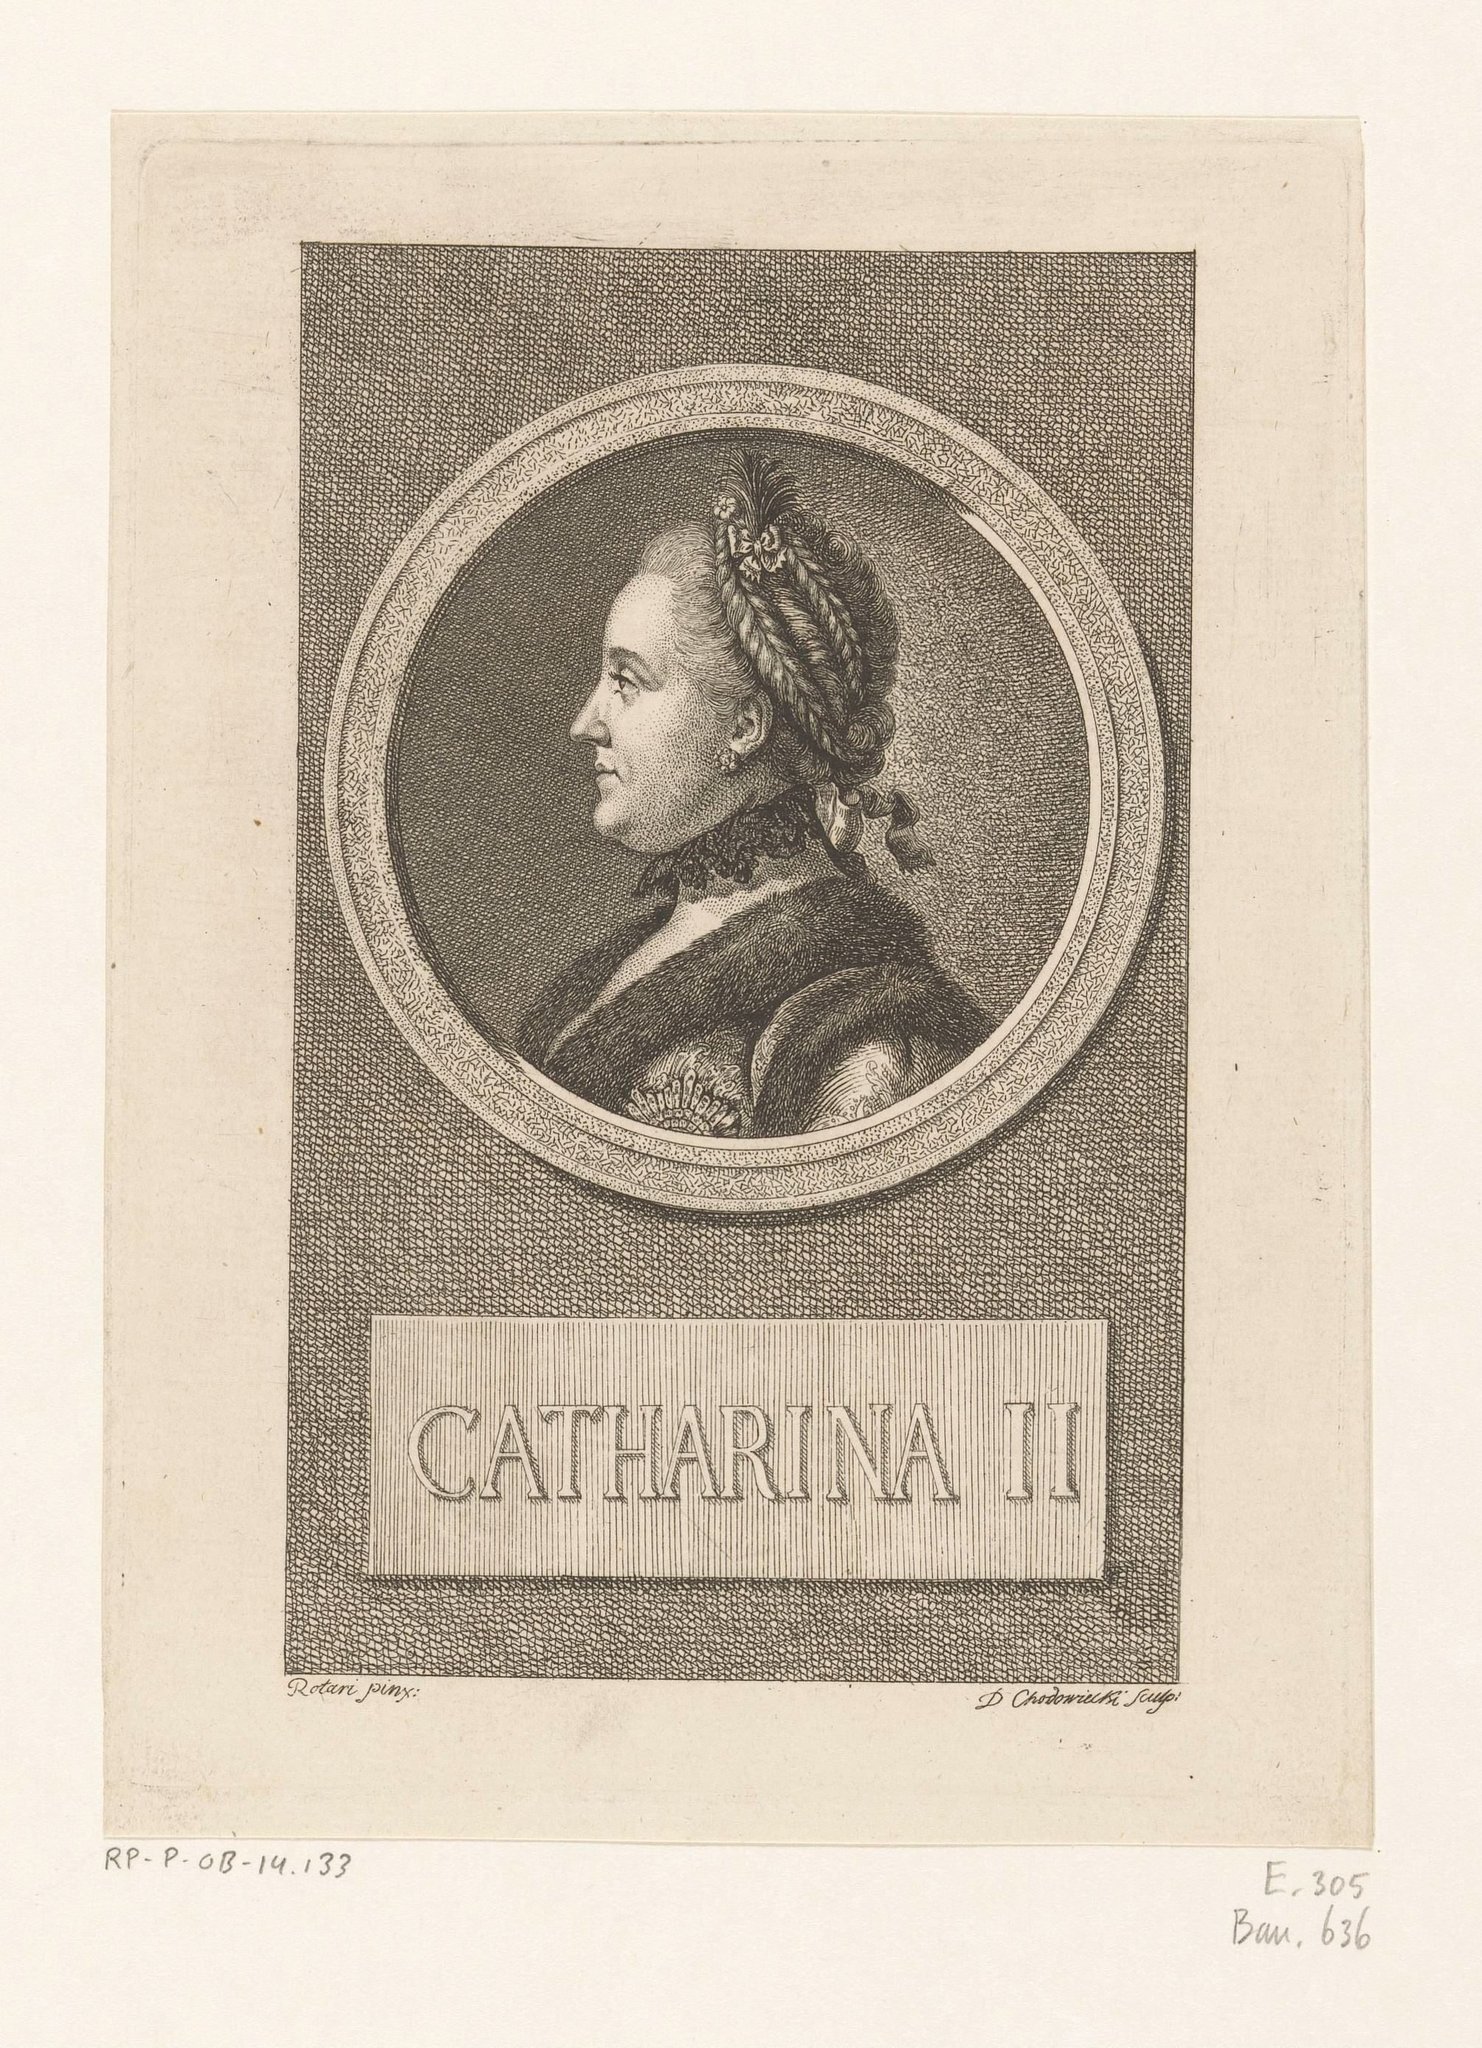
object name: print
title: Portret van Catharina de Grote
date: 1779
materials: paper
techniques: etching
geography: berlin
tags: catharina de grote, historical persons - bb - woman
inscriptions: collector's mark: Lugt 240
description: Prent ook gebruikt in: Krünitz, Johann Georg. Oekonomische Encyklopädie. Berlijn: Joachim Pauli, 1779, dl. 16.